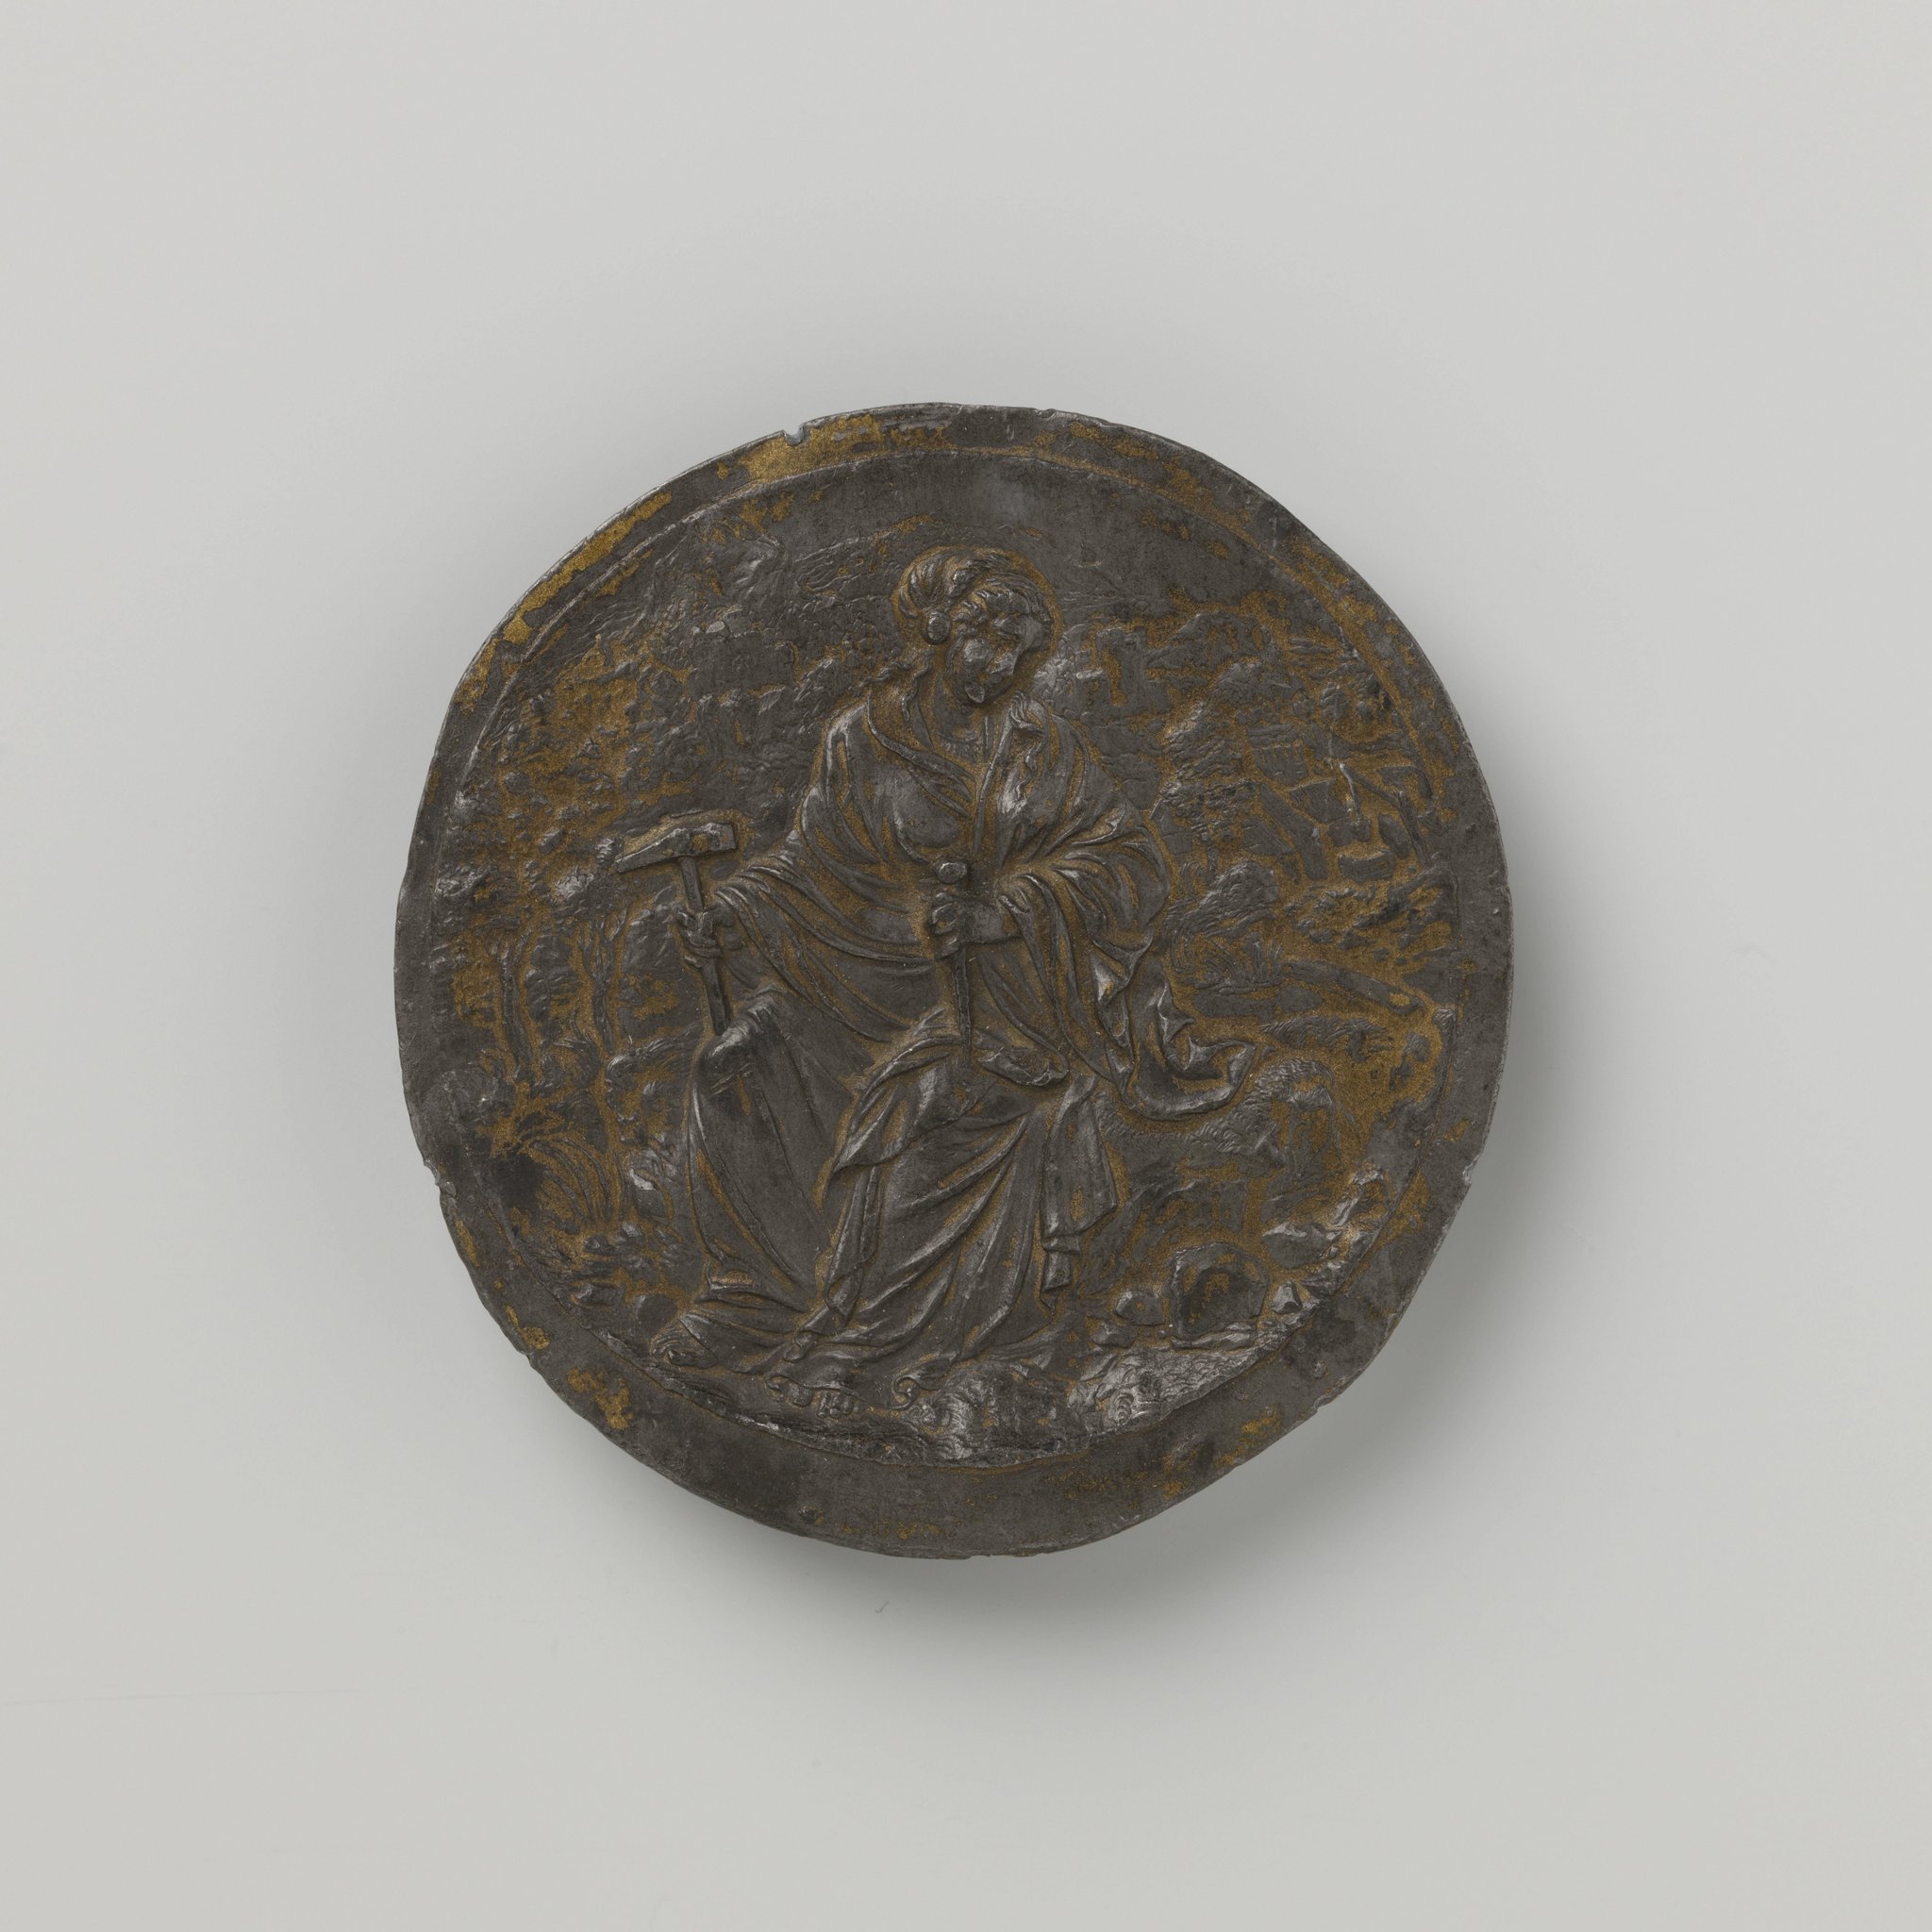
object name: plaque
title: Jaël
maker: peter flötner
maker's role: print maker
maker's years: 1485-1546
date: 1525-1550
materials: lead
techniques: gilding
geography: nuremberg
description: Ronde, loden, plaquette met afgeschuinde randen. Op een rotsachtige terreinverhoging zit een vrouw in een ruim geplooid gewaad, het lichaam naar links, het hoofd naar rechtsgewend. In haar rechterhand houdt zij de hamer, in haar linker de spijker waarmede zij Jisera, krijgsoverste der Kanaäniten, in de slaap vermoordde. Op de achtergrond een berglandschap en gebouwen. Rechts een boerenhofstede waarbij een put.